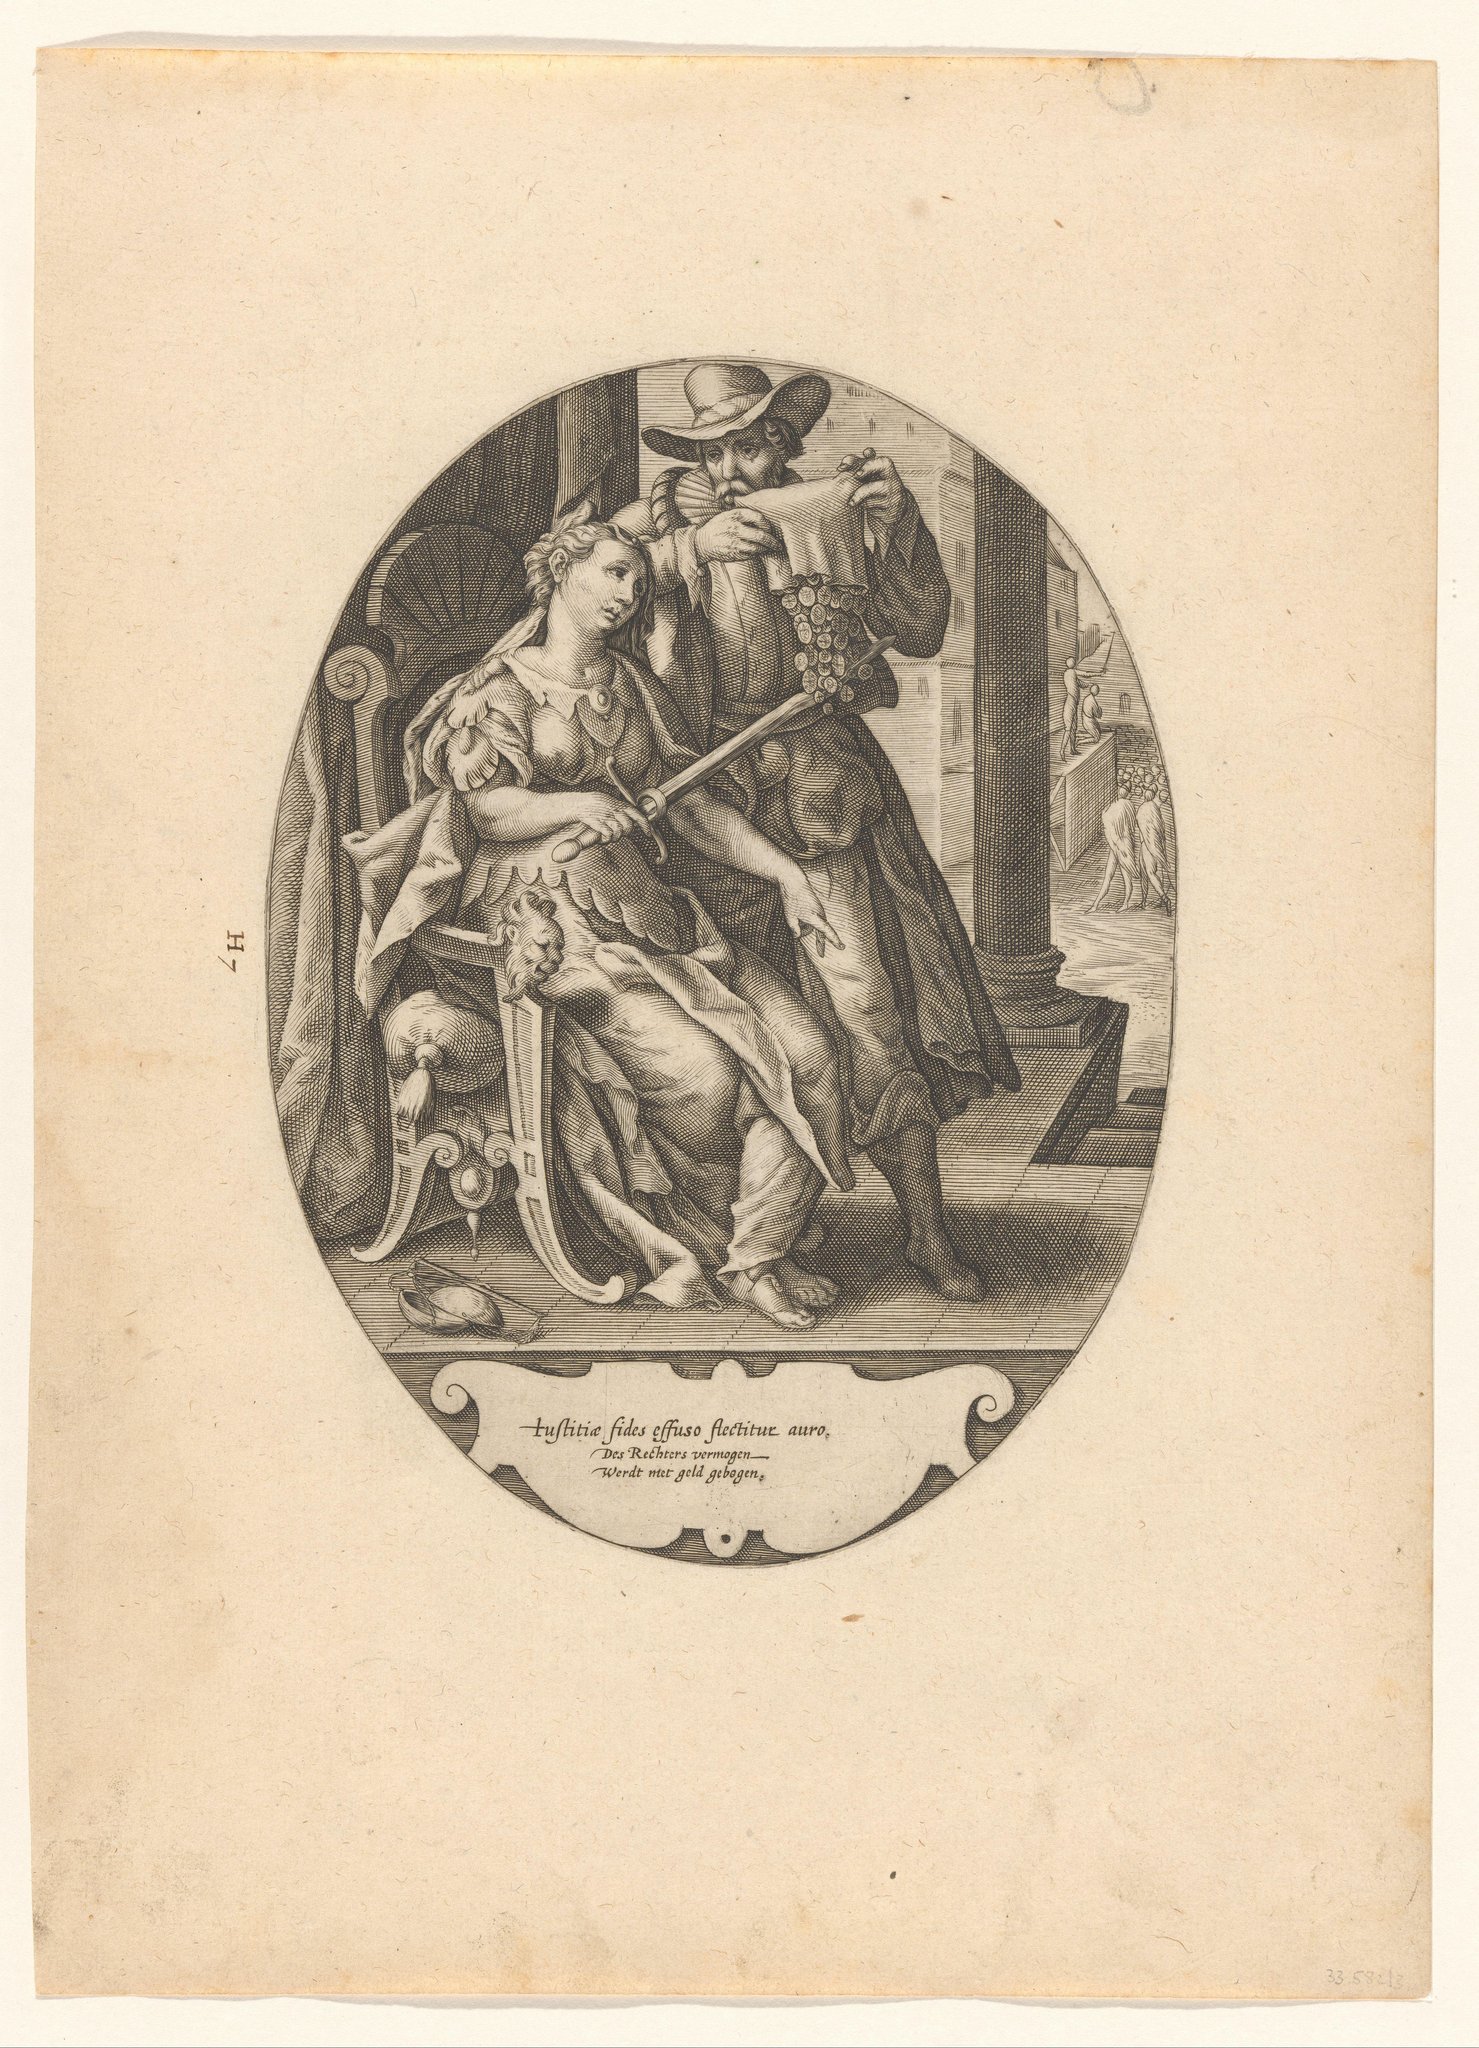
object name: print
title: Gerechtigheid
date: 1590-1610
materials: paper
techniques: engraving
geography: amsterdam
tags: justice, 'justitia'; 'giustitia divina' (ripa) ~ one of the four cardinal virtues, incorruptibility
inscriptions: collector's mark: Lugt 2228, collector's mark: Lugt 2760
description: Prent uit een reeks met vrouwelijke personificaties van Deugden en Ondeugden van onbekende omvang. Een zelfde type gravure met een vergelijkbare personificatie van de Ondeugd Superbia is voorzien van opschriften waarin Jacob Leenders en Lambert Jacobsz worden vermeld als respectievelijk de ontwerper en de graveur. Exemplaren bevinden zich in Göttweich Abbey, The Metropolitan Museum of Art in New York en bij kunsthandel Hill-Stone. Andere afdrukken van de onderhavige prenten zijn niet beschreven. Of zij tot dezelfde reeks behoren of tot een andere reeks met Deugden is vooralsnog onbekend.